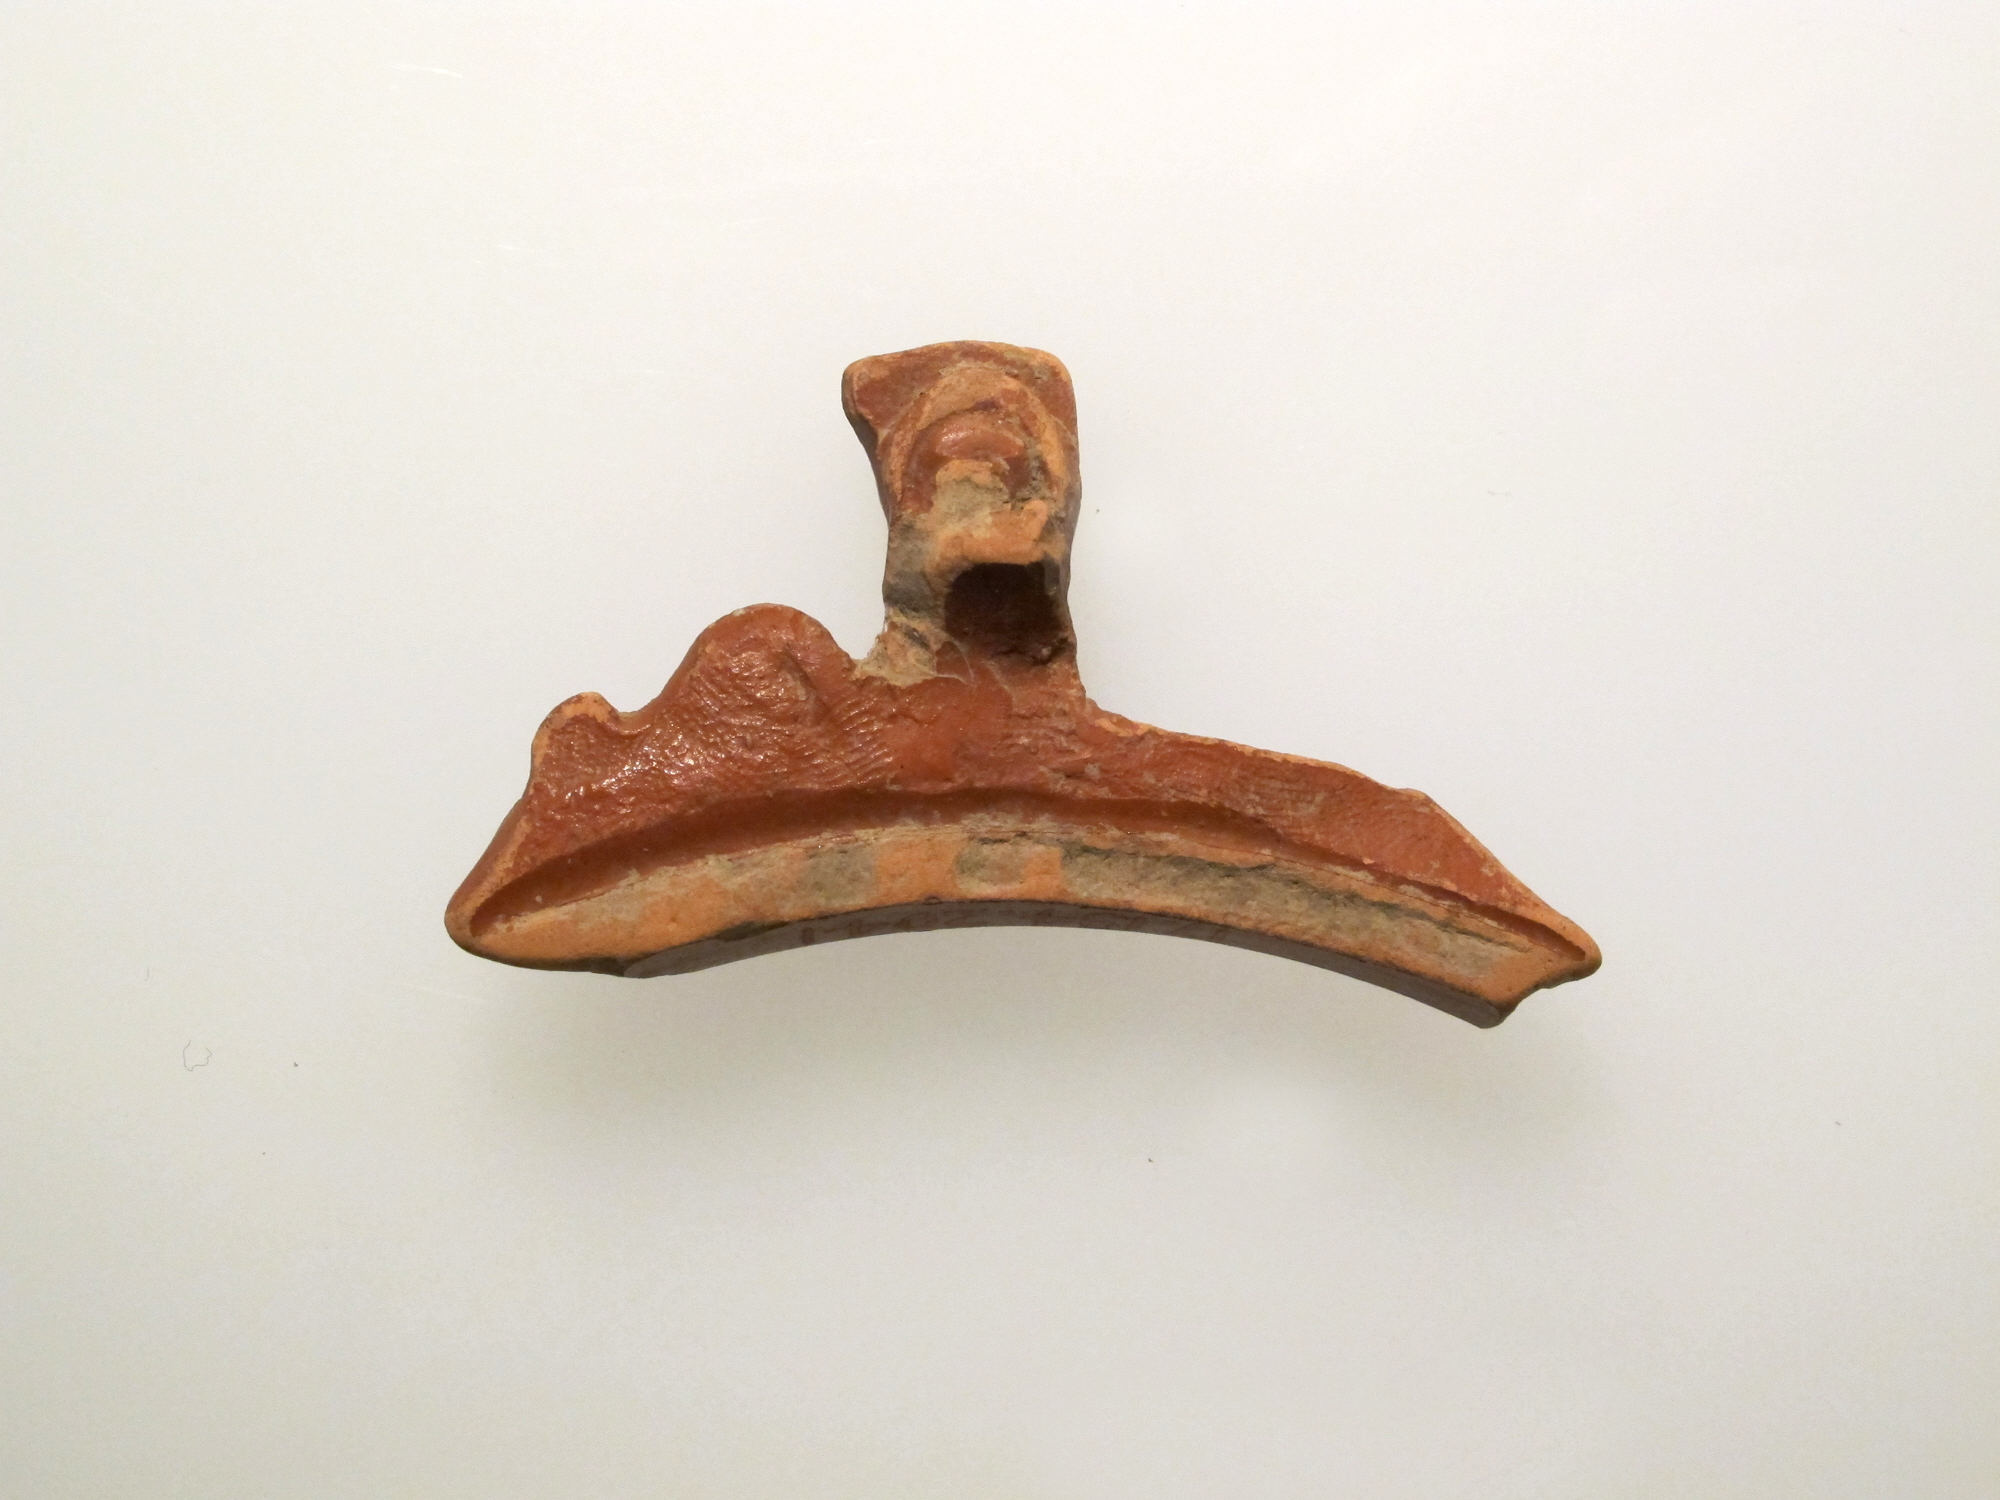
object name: vase fragment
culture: roman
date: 100 BCE-100 CE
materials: terracotta